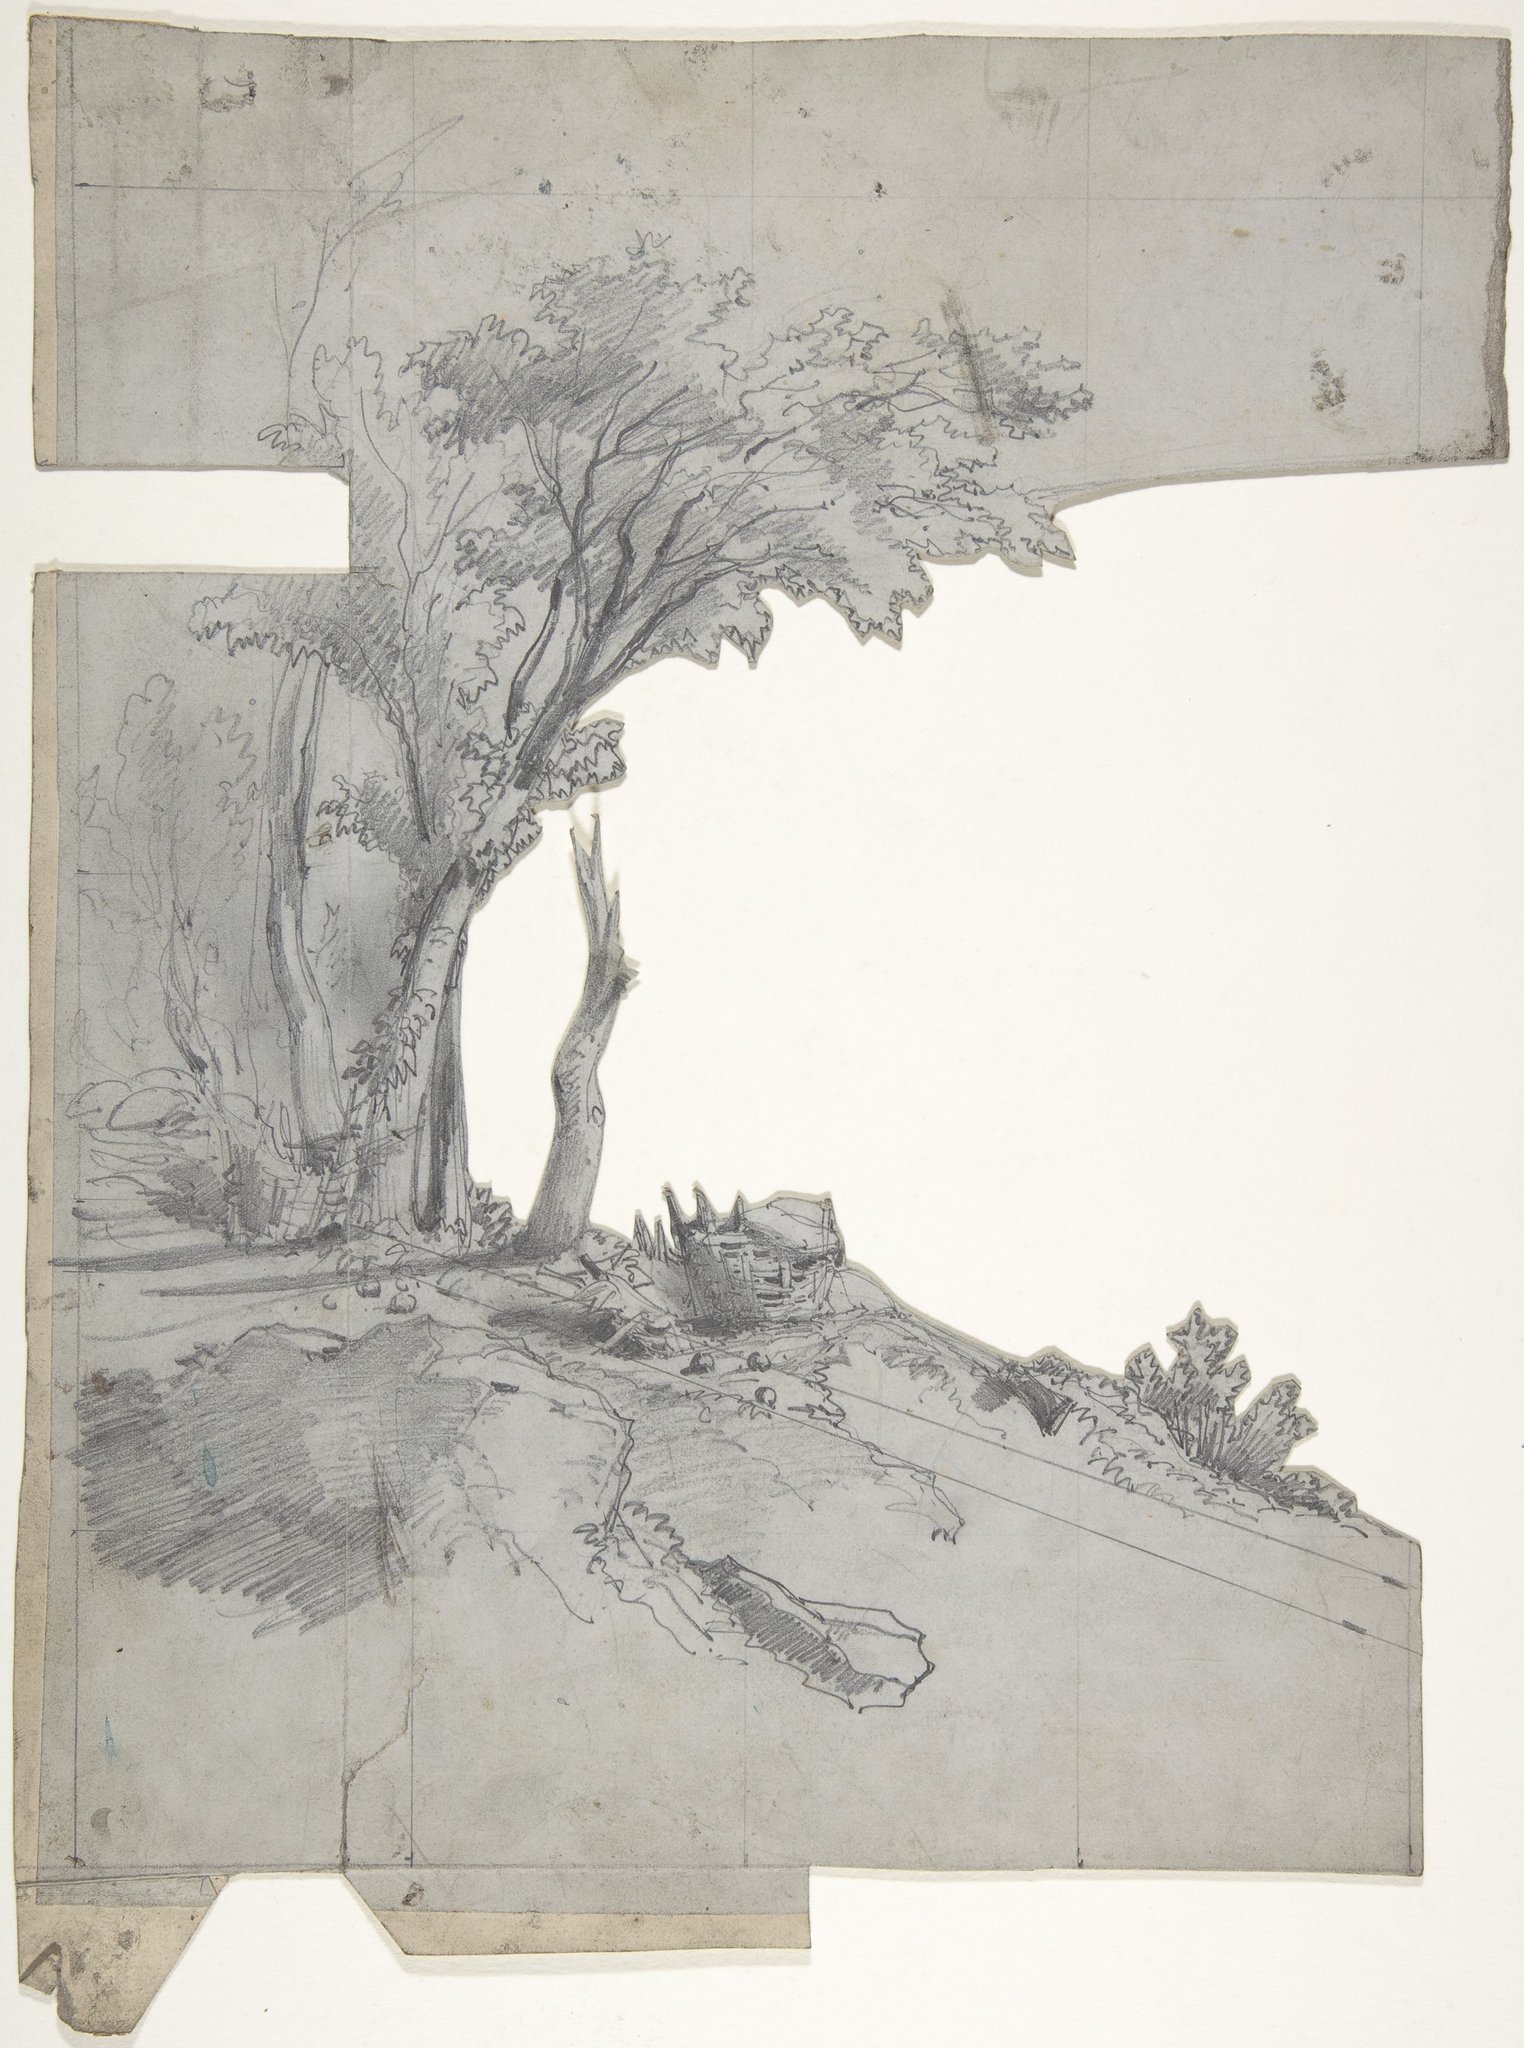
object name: drawing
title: Design for a Stage Set at the Opéra, Paris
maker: eugène cicéri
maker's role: artist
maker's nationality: french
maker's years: 1813-1890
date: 1830-1890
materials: graphite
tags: trees,stage design